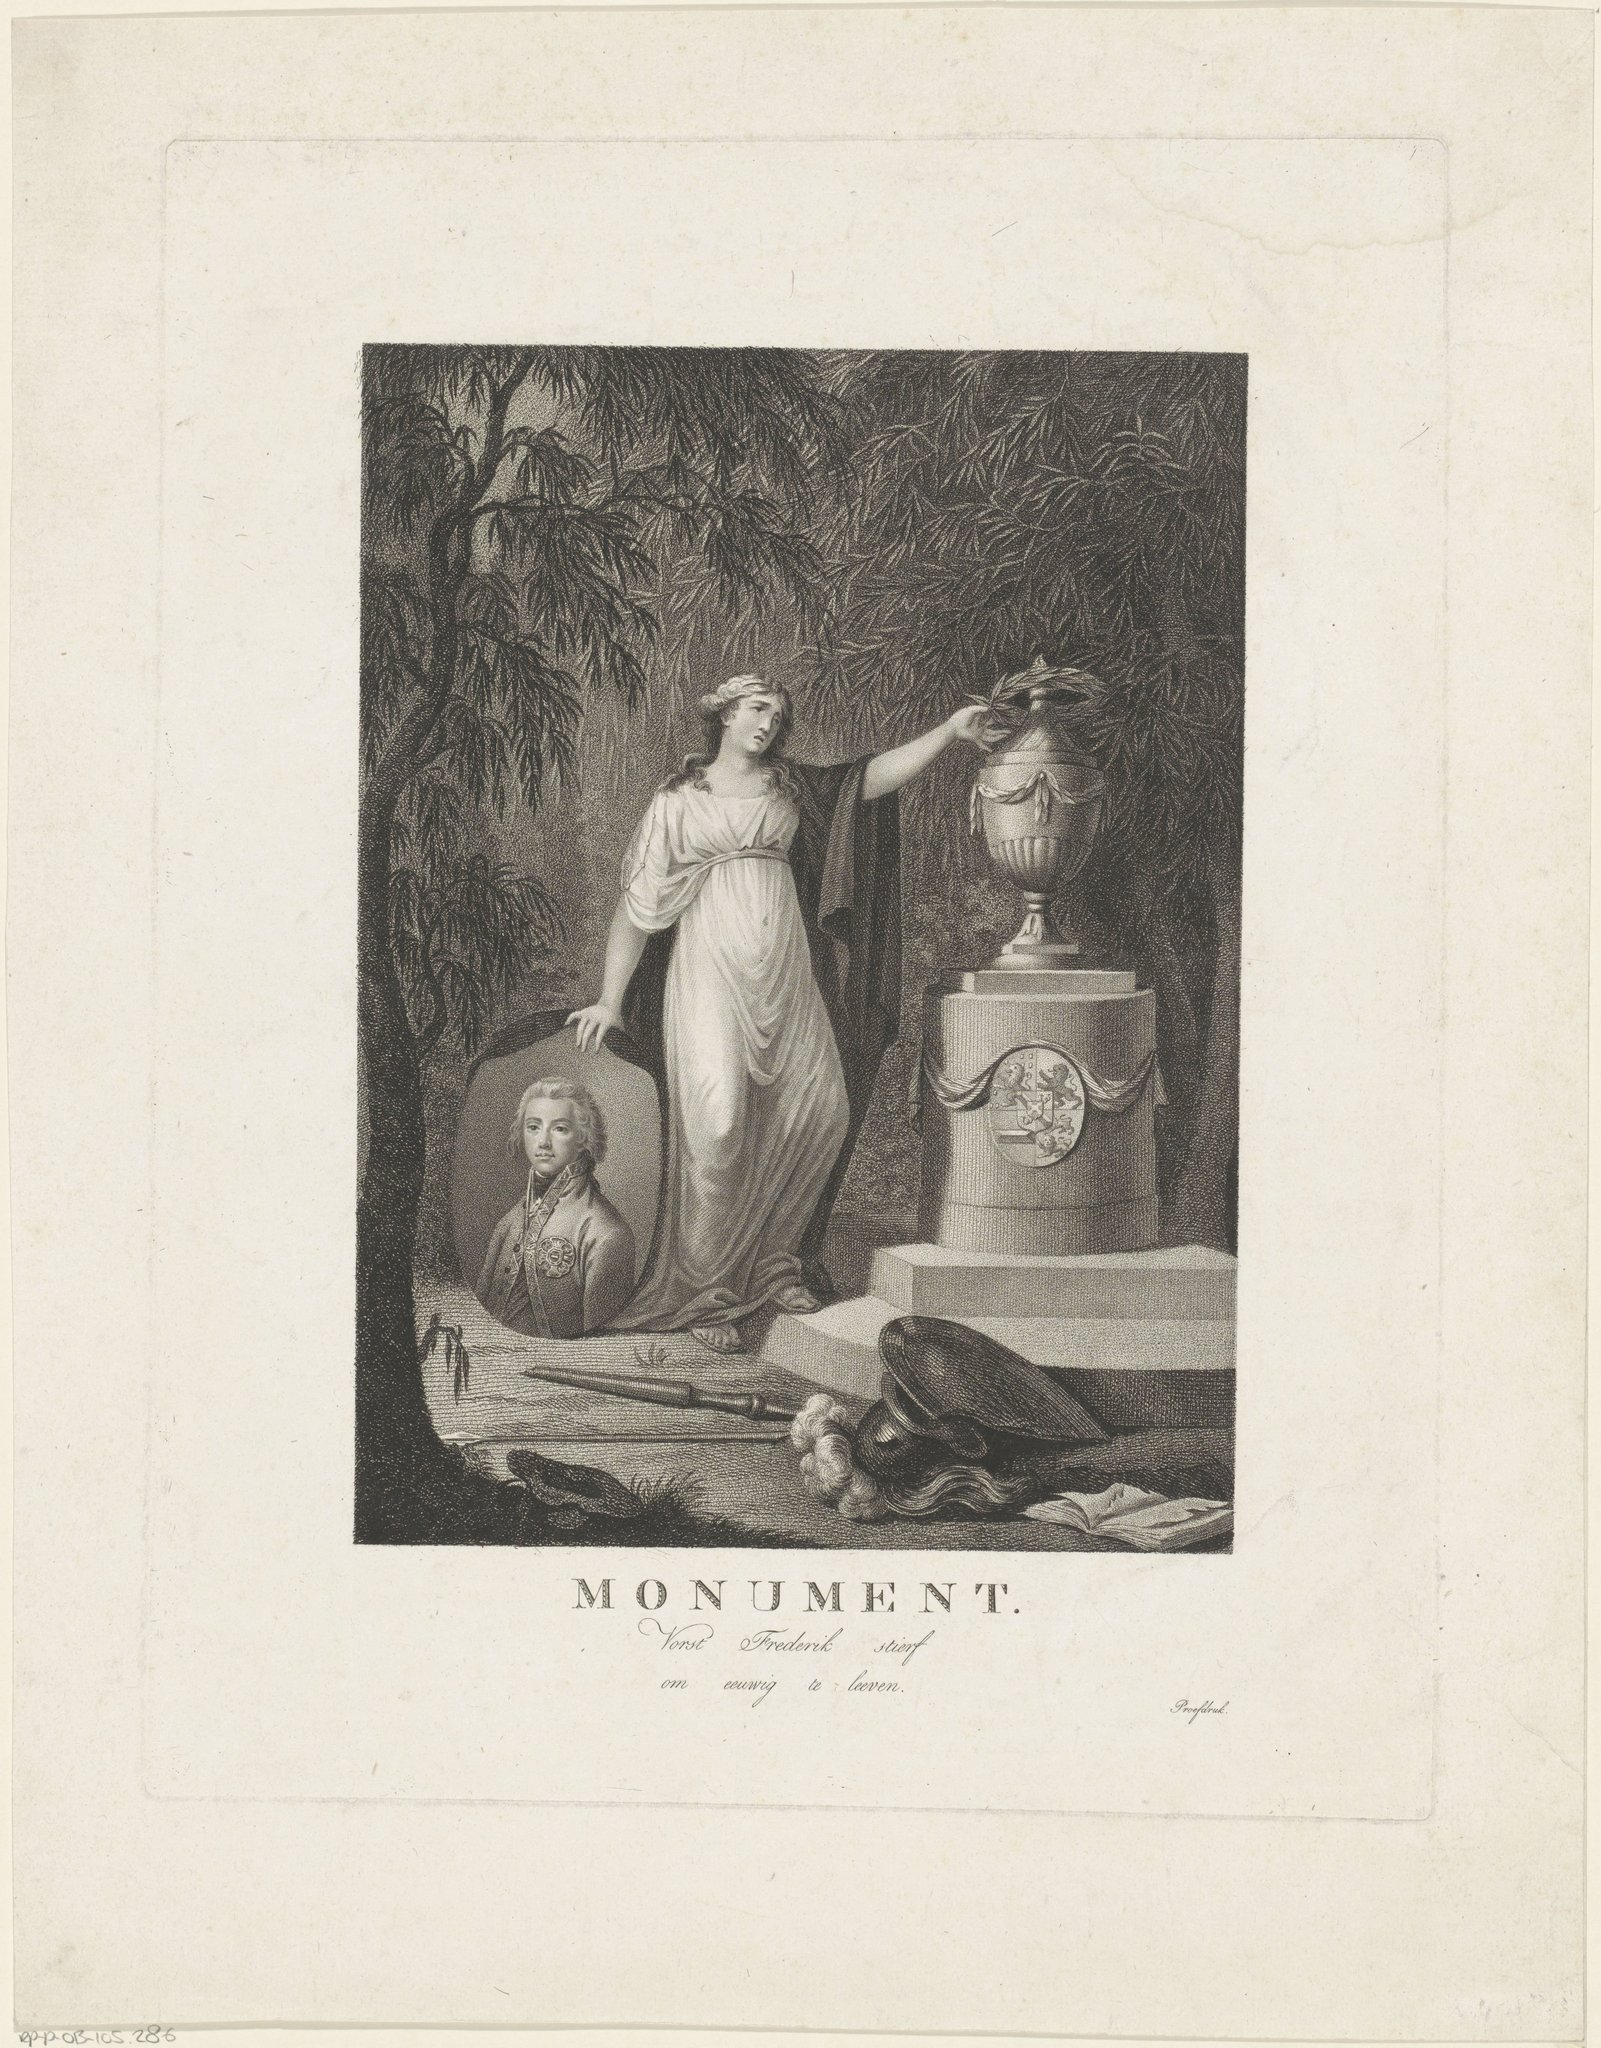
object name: print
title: Allegorisch grafmonument voor Frederik, prins van Oranje-Nassau, 1799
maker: Anonymous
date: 1799-1801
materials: paper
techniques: engraving, etching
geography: low countries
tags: the hague, willem george frederik (prins van oranje-nassau), grave-building, monumental tomb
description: Allegorisch grafmonument voor Frederik, overleden te Padua op 6 januari 1799. Portret van Frederik in een ovaal. Daar omheen een aantal allegorische objecten en de Nederlandse Maagd. In de ondermarge drie regels Nederlandse tekst. Rechtsonder 'Proefdruk.'.